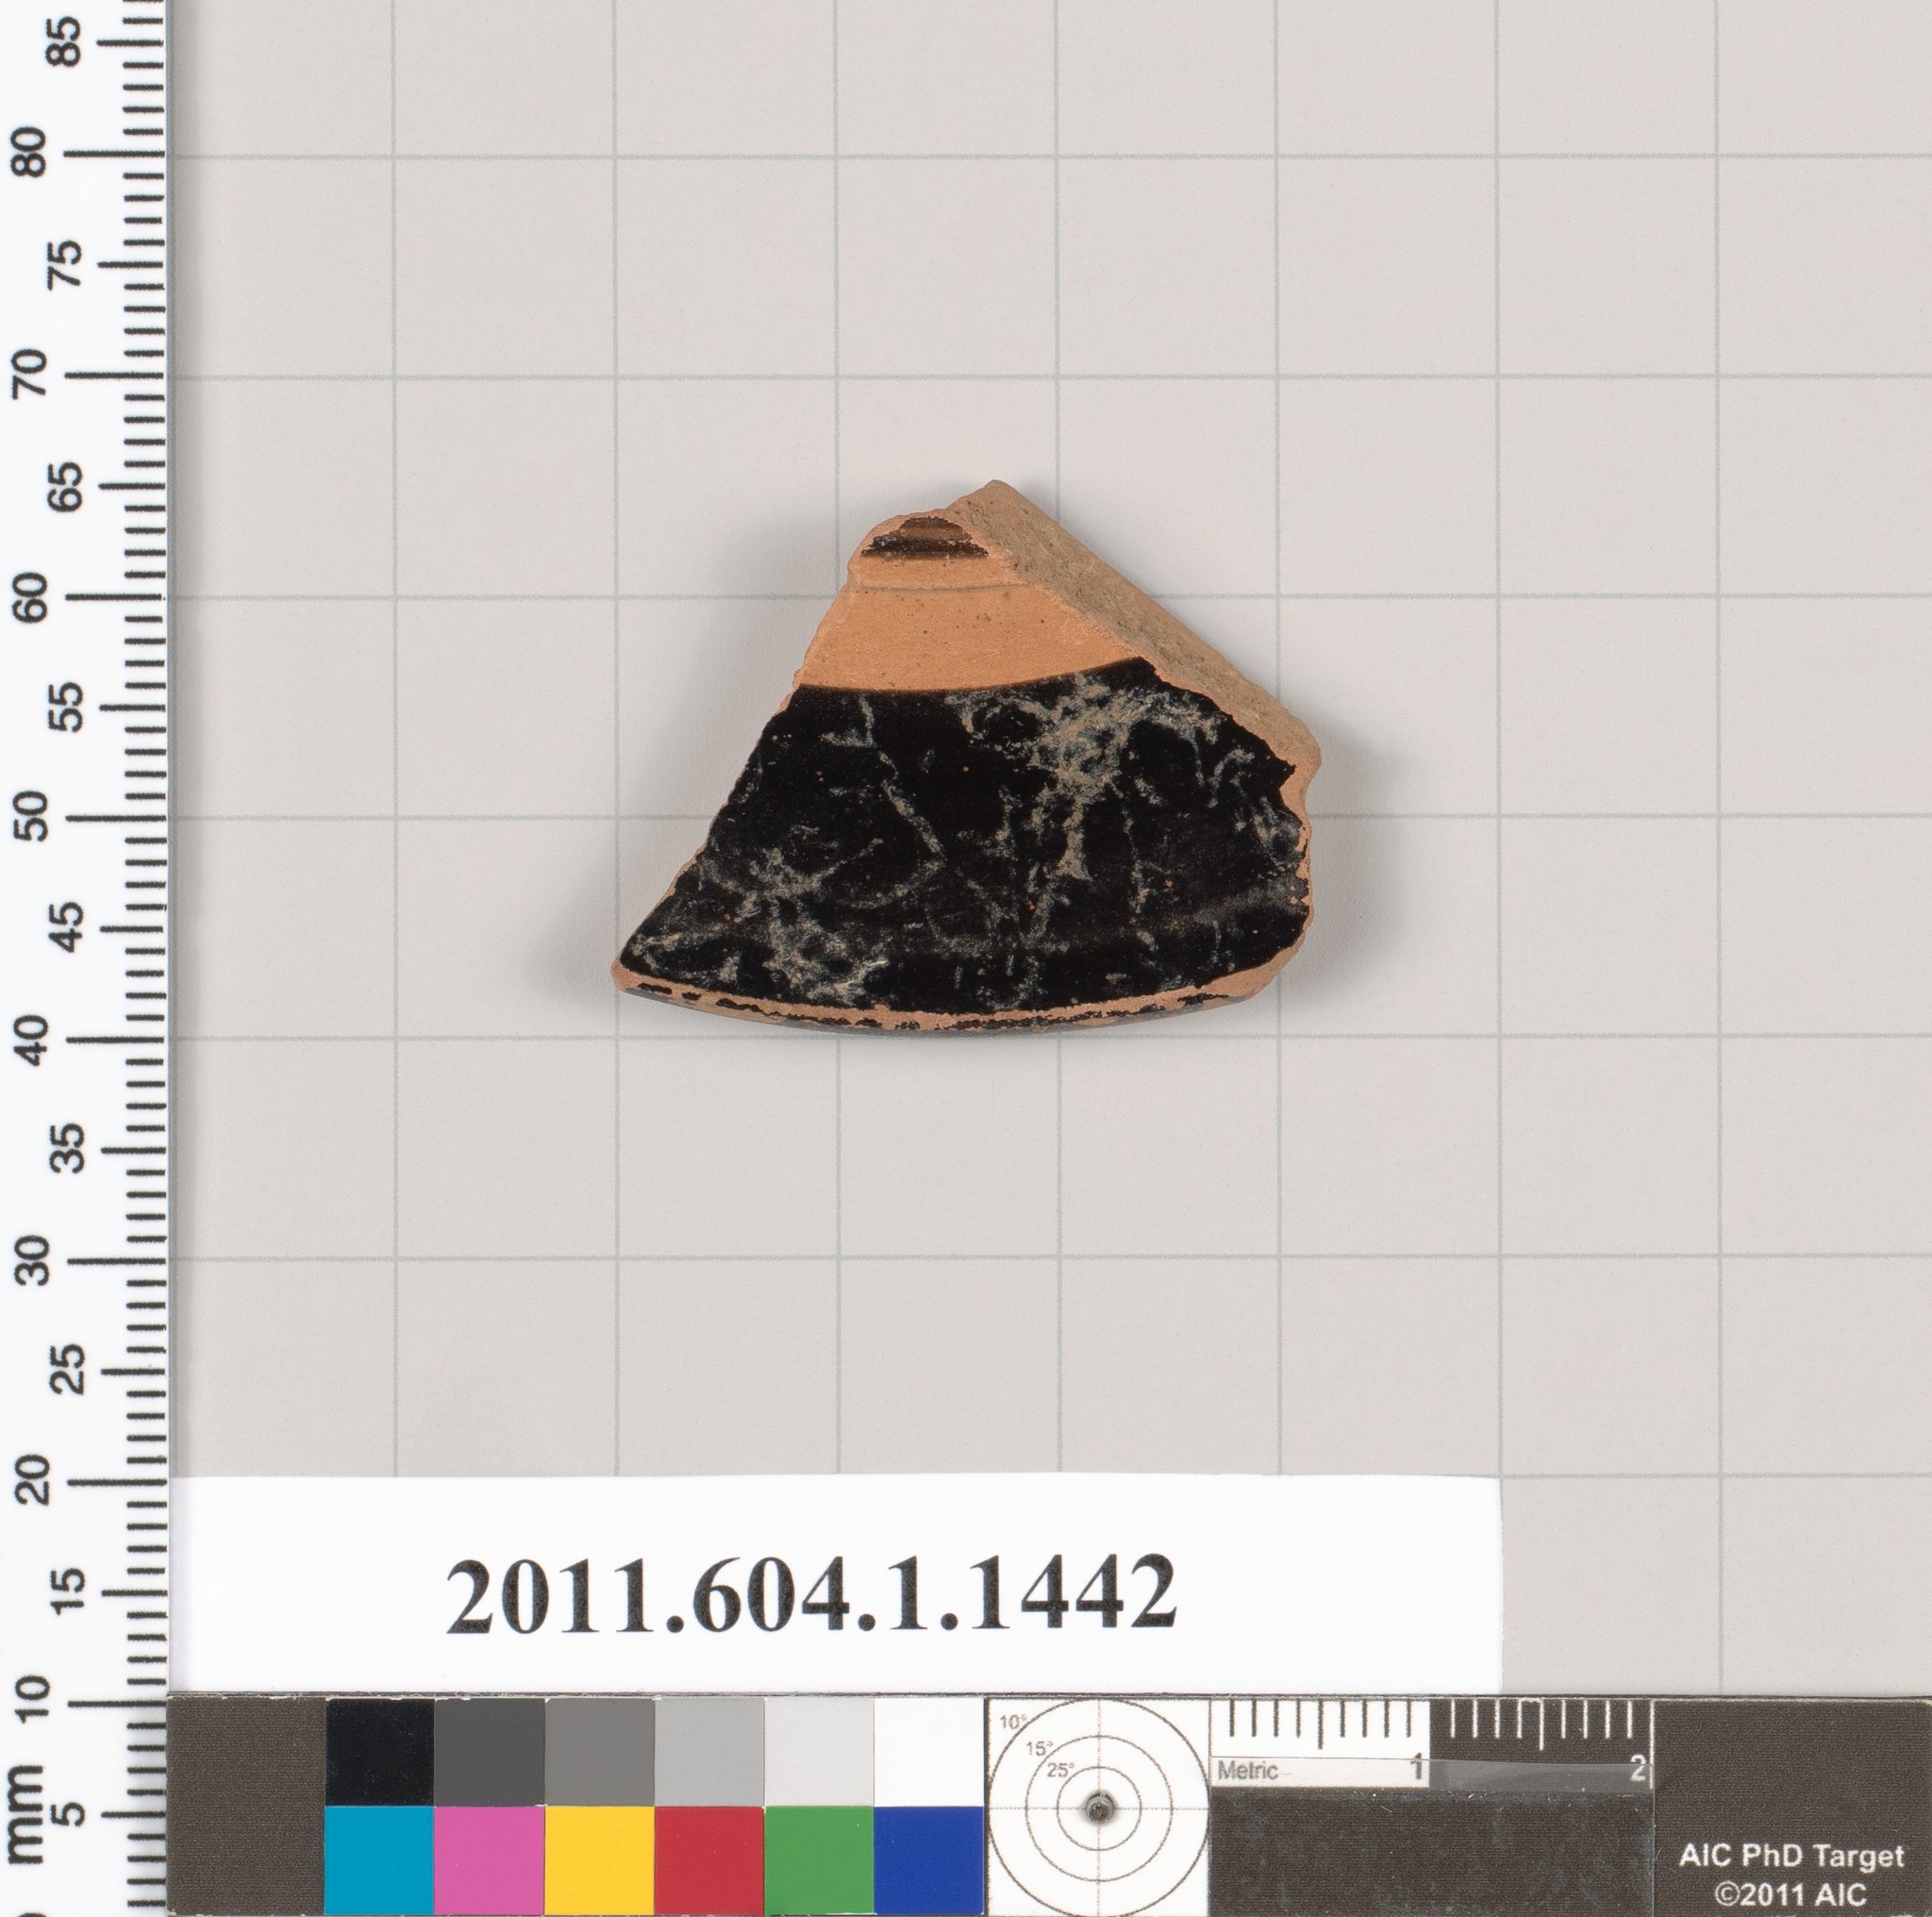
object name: kylix fragment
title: Terracotta fragment of a kylix (drinking cup)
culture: greek, attic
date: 500-401 BCE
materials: terracotta